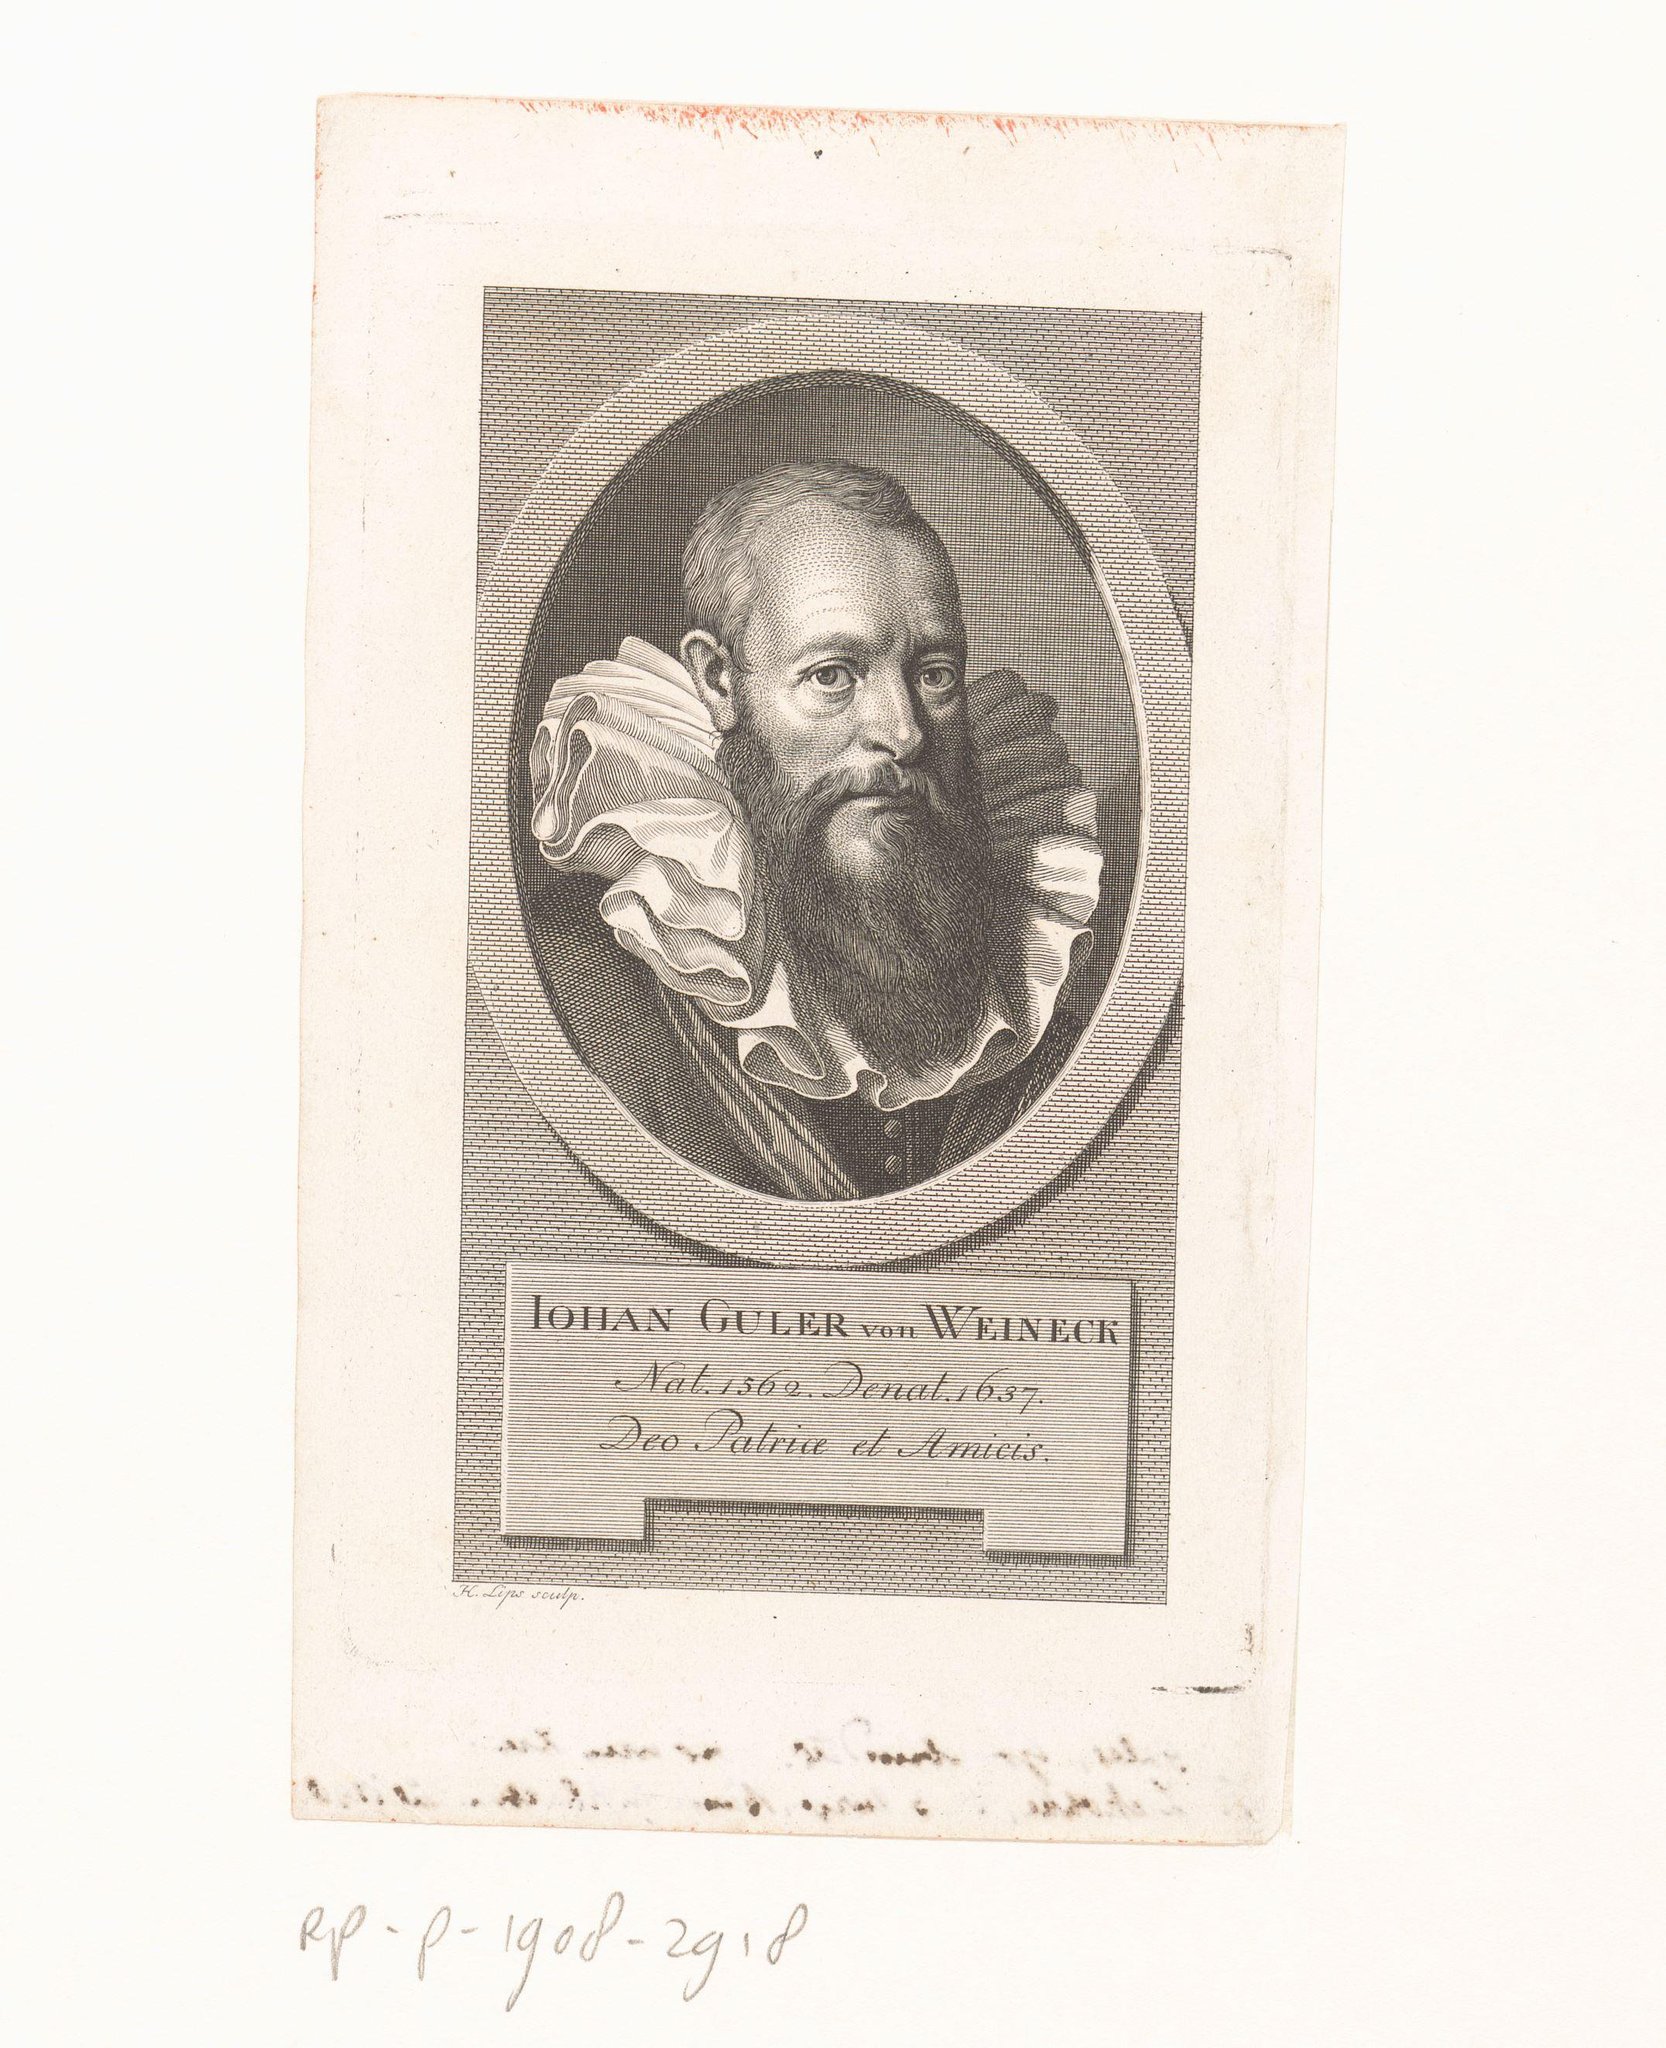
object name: print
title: Portret van Johannes Guler von Wyneck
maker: johann heinrich lips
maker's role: draughtsman, painter, print maker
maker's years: 1758-1817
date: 1768-1817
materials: paper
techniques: engraving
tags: historical persons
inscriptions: collector's mark: Lugt 2228